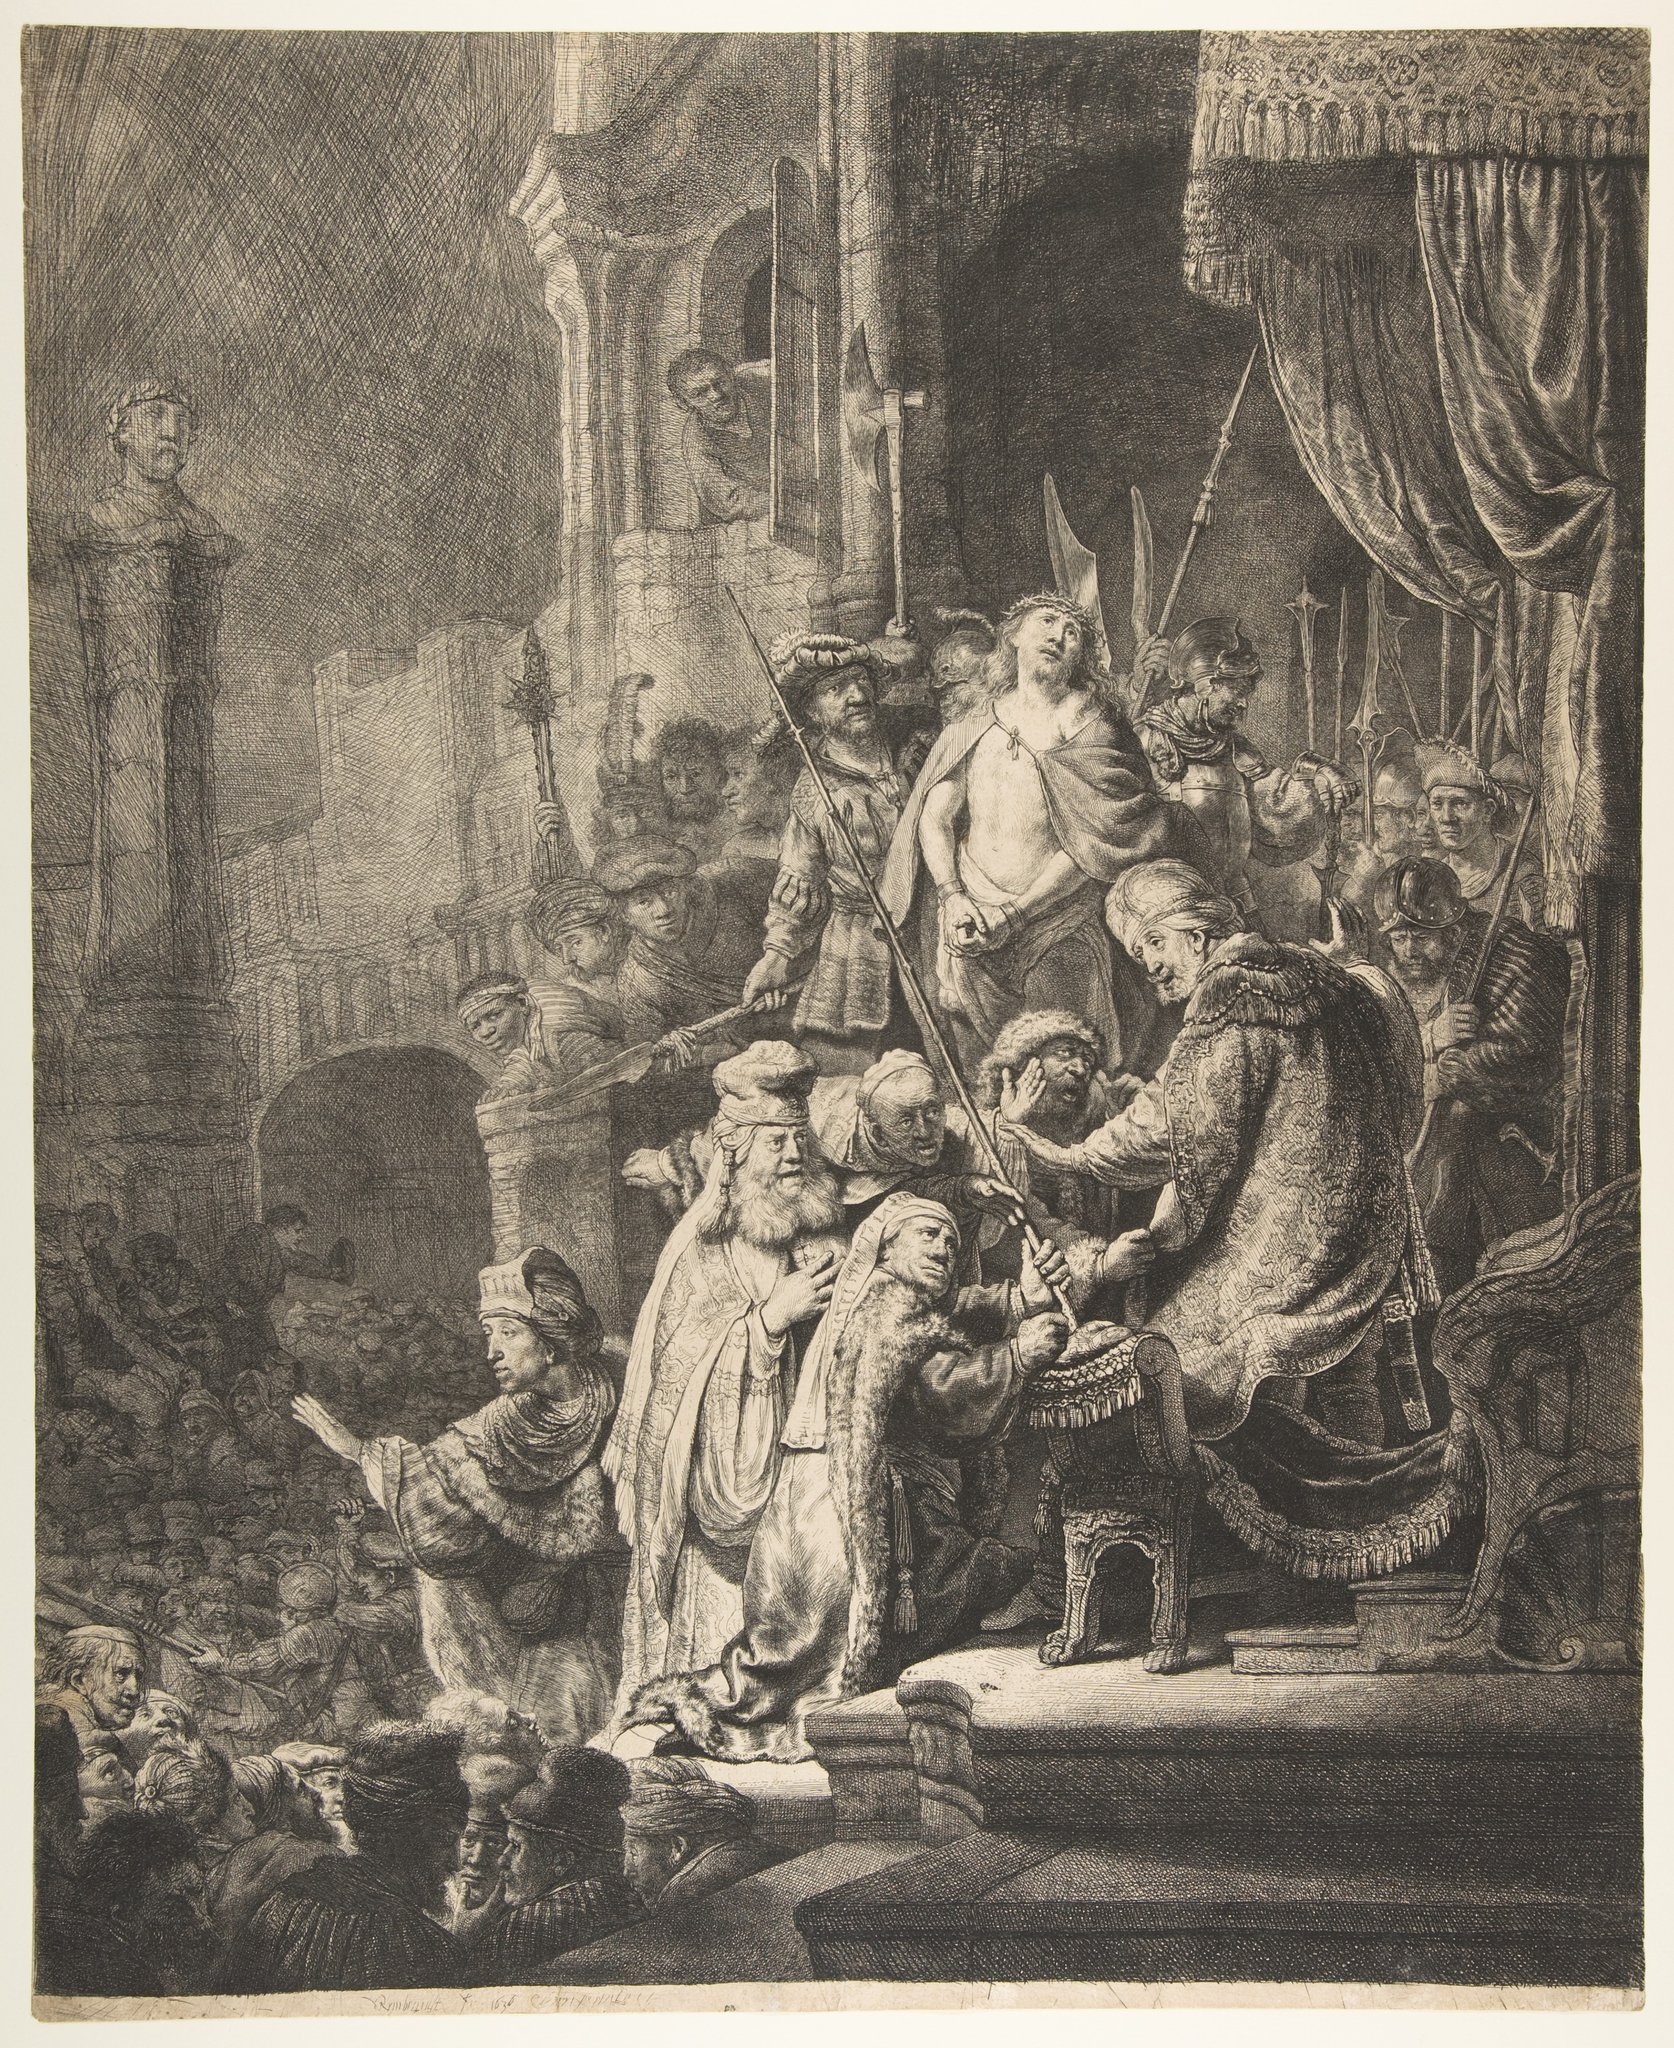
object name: print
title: Christ Before Pilate: the large plate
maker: rembrandt van rijn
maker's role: artist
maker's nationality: dutch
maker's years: 1606-1669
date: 1636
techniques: etching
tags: men,christ,pilate